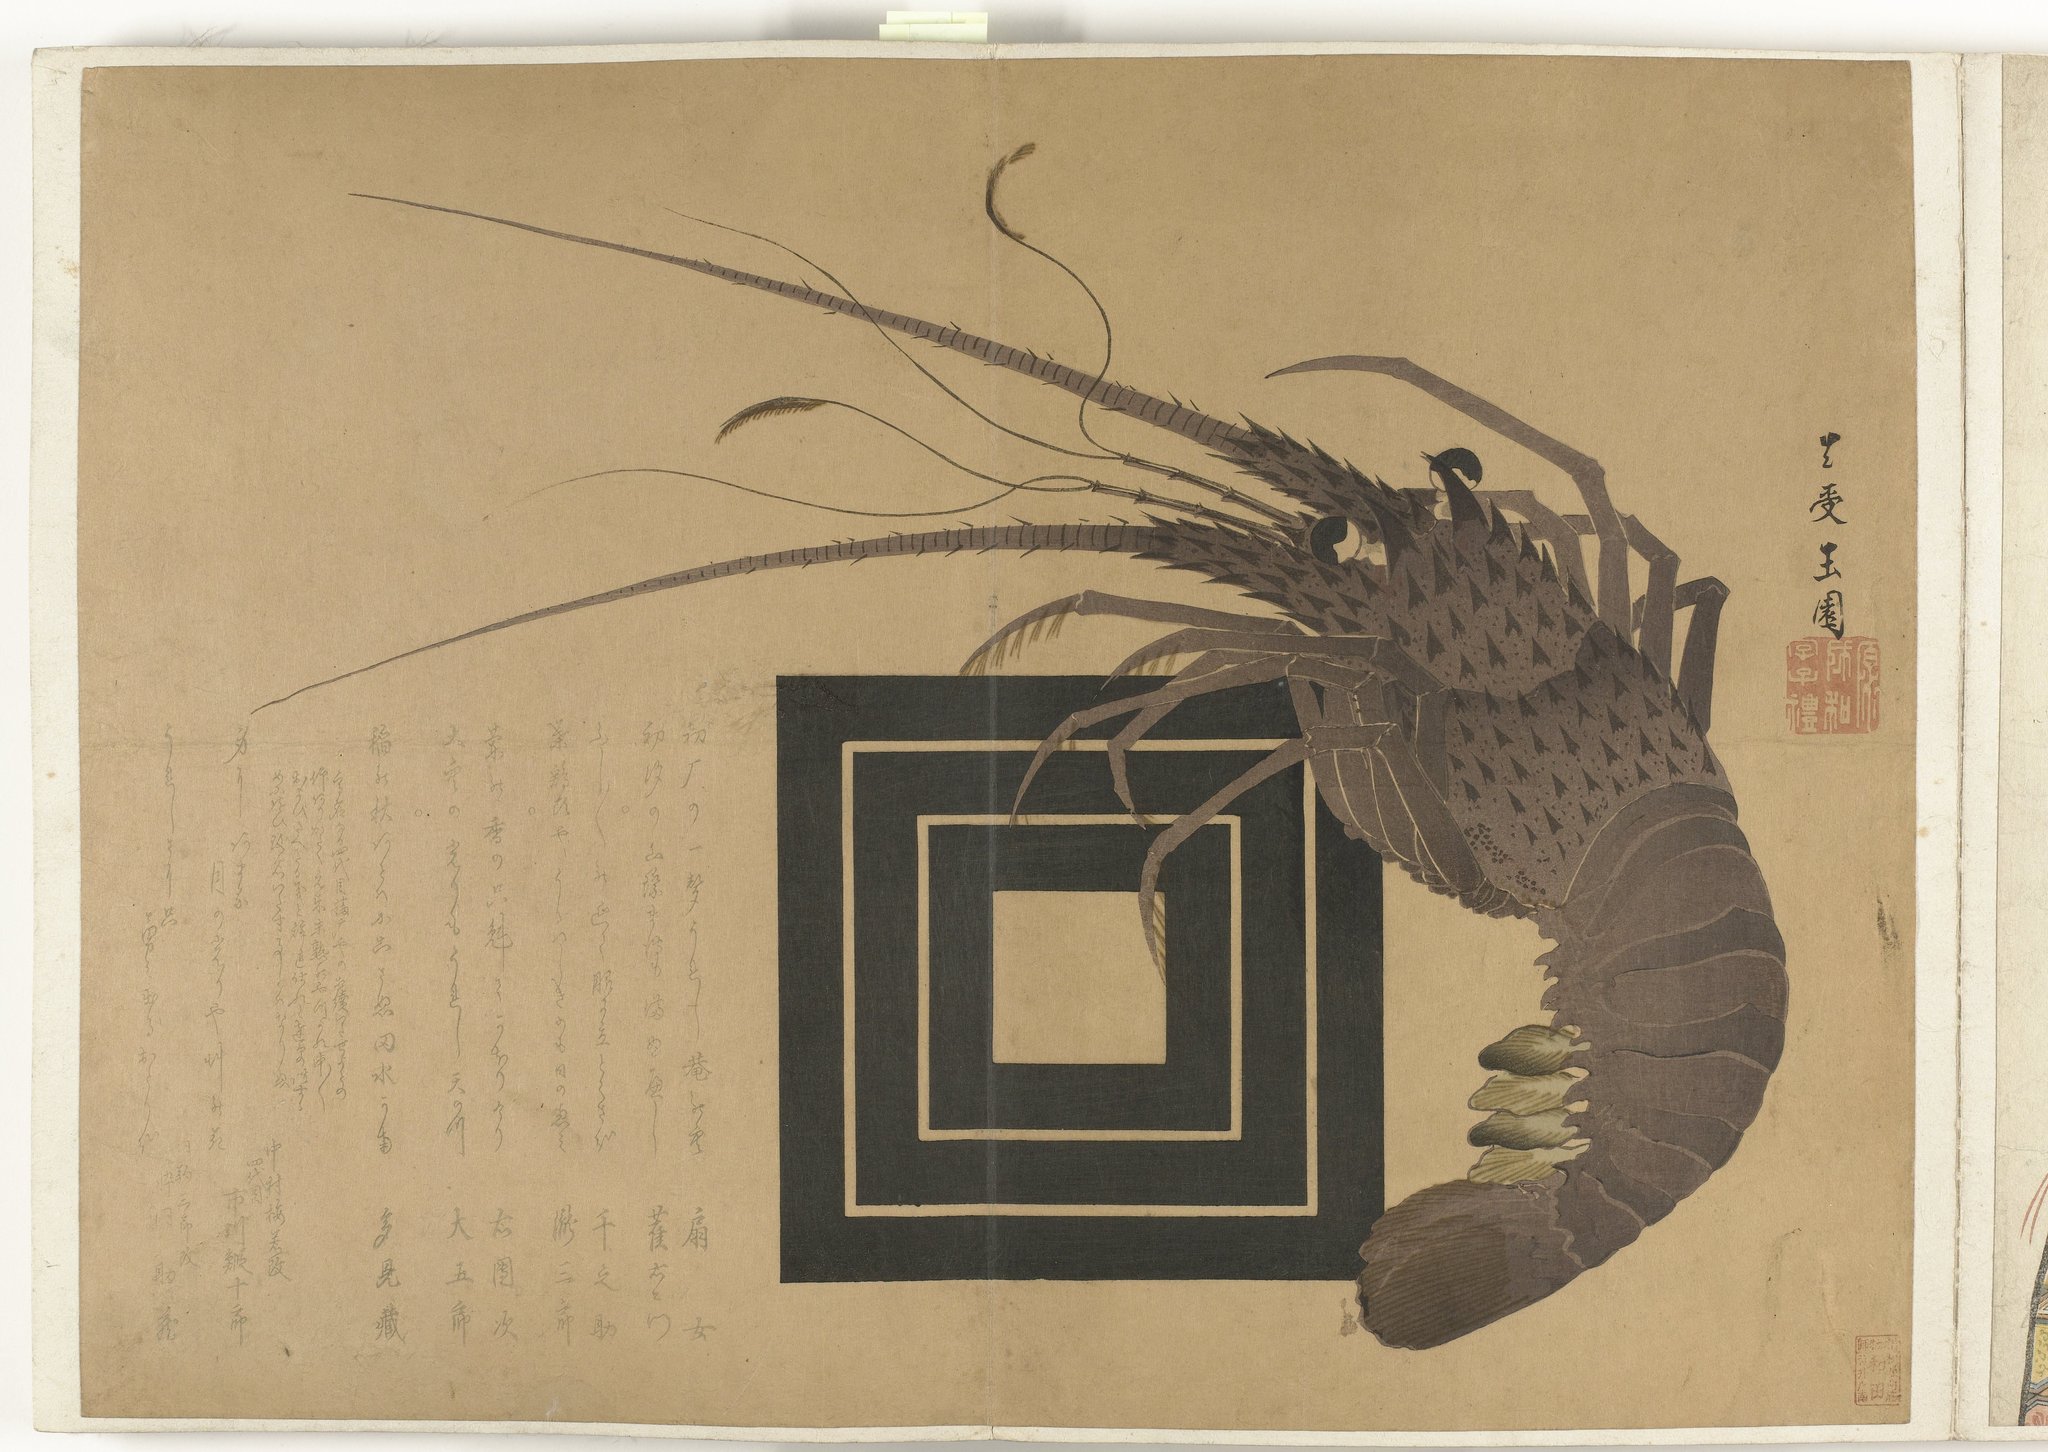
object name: print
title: Kreeft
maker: Anonymous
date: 1840-1900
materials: paper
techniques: woodcut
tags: regular quadrilateral: square, crustaceans: lobster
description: Een surimono is een luxe uitgevoerde prent waarop beeld met één of meerdere gedichten gecombineerd is. Bij het drukken van een surimono werd vaak gebruik gemaakt van dikker papier, blinddruk en metaal pigmenten, zoals koper- en zilverpoeder. De prenten werden vaak in opdracht van dichters gemaakt en als exclusief geschenk aan vrienden en relaties gegeven.